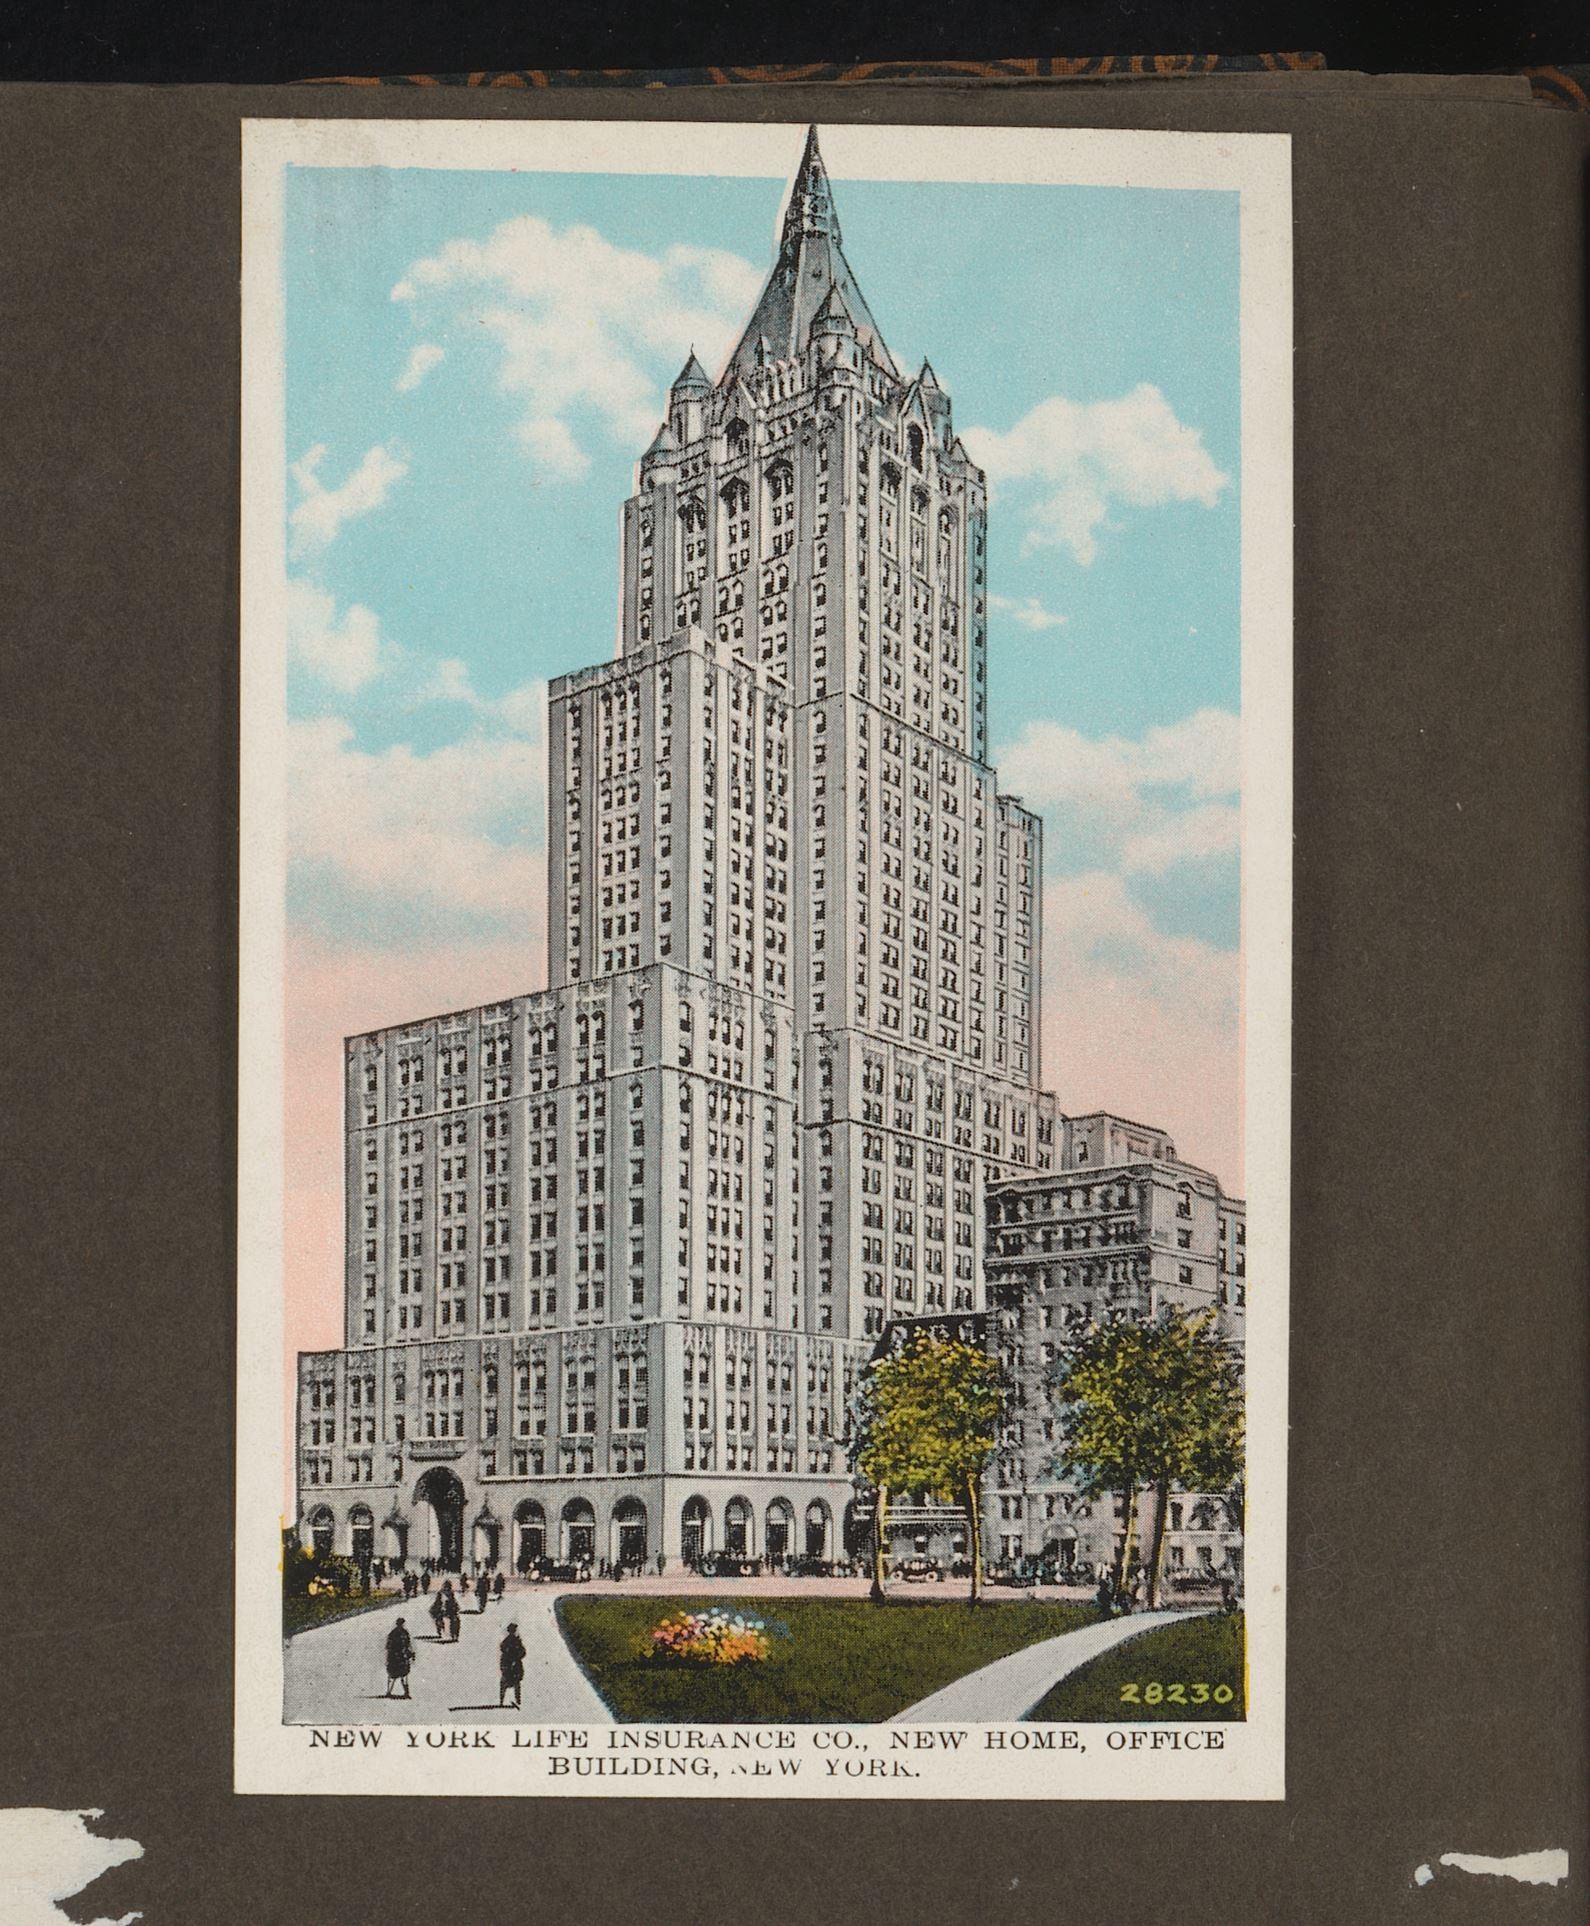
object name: album leaf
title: New York life insurance co. New Home, Office building, New York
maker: Anonymous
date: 1928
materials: paper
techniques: four-color autotype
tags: skyscraper, new york (city)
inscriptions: number: ‘28230’